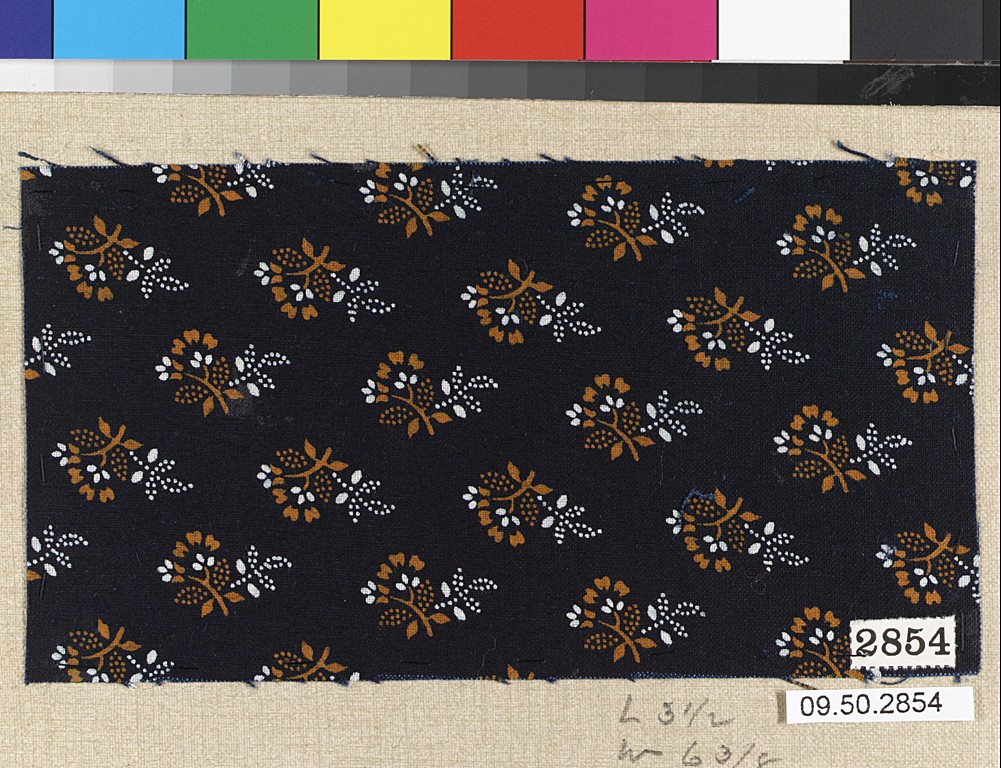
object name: piece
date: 1801-1900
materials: cotton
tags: leaves